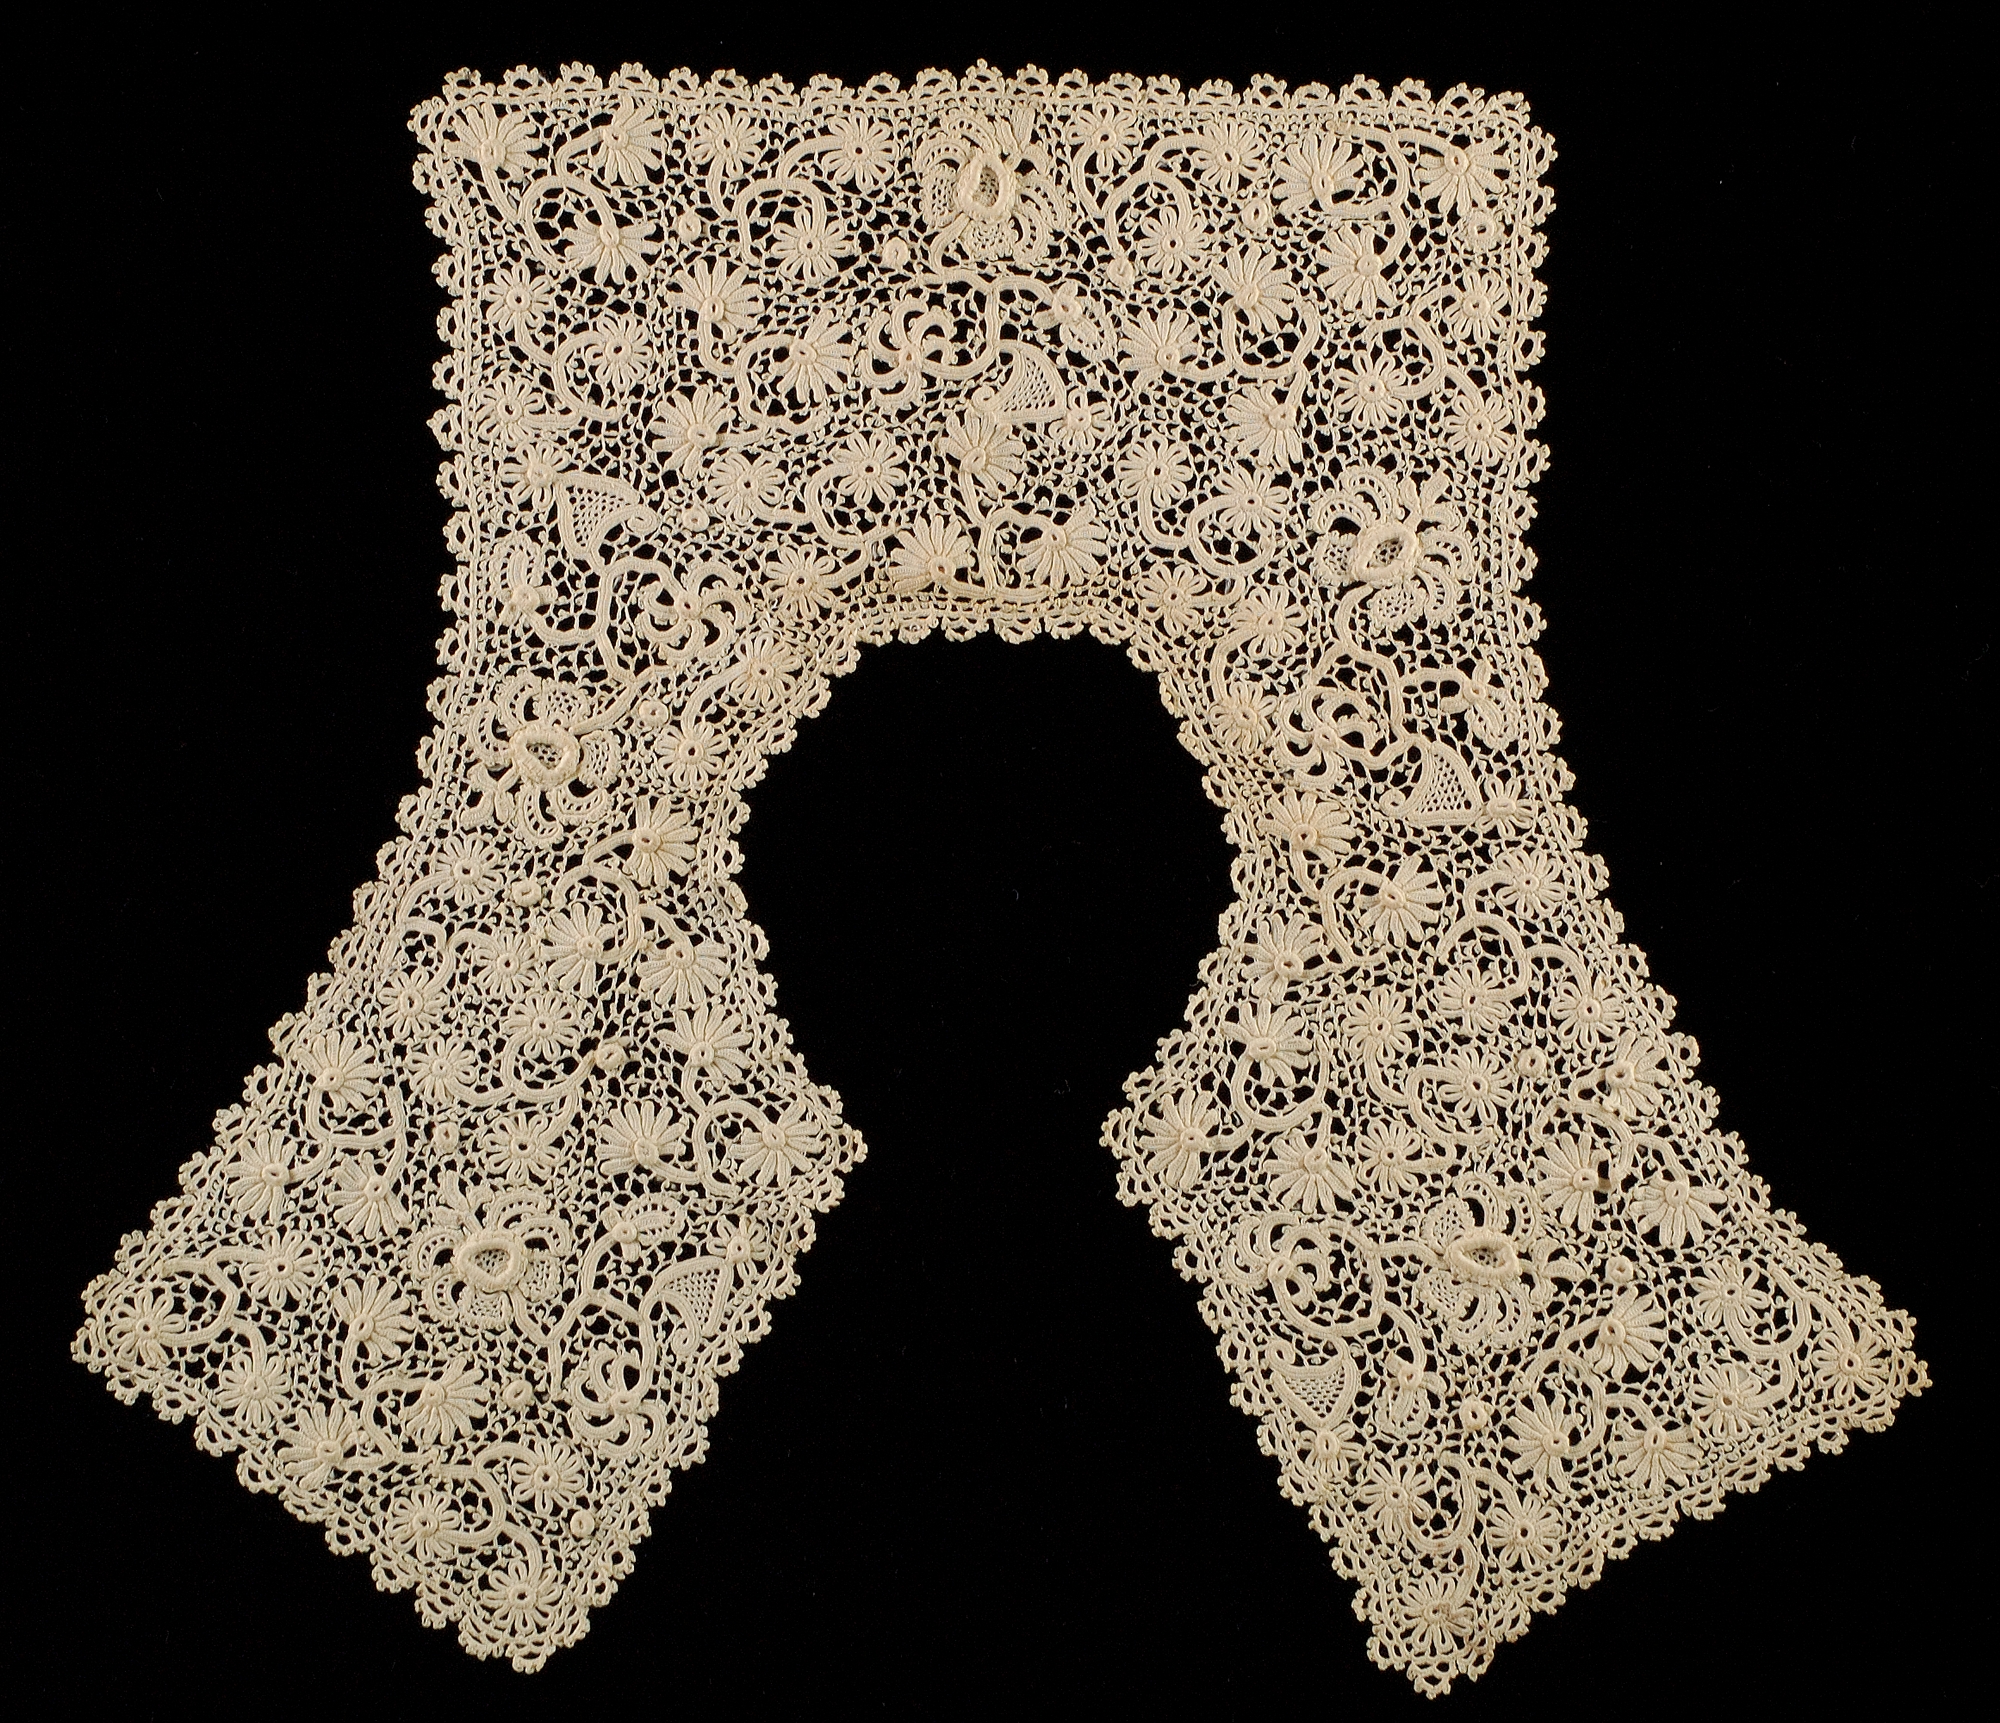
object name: collar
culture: irish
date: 1867-1900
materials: cotton